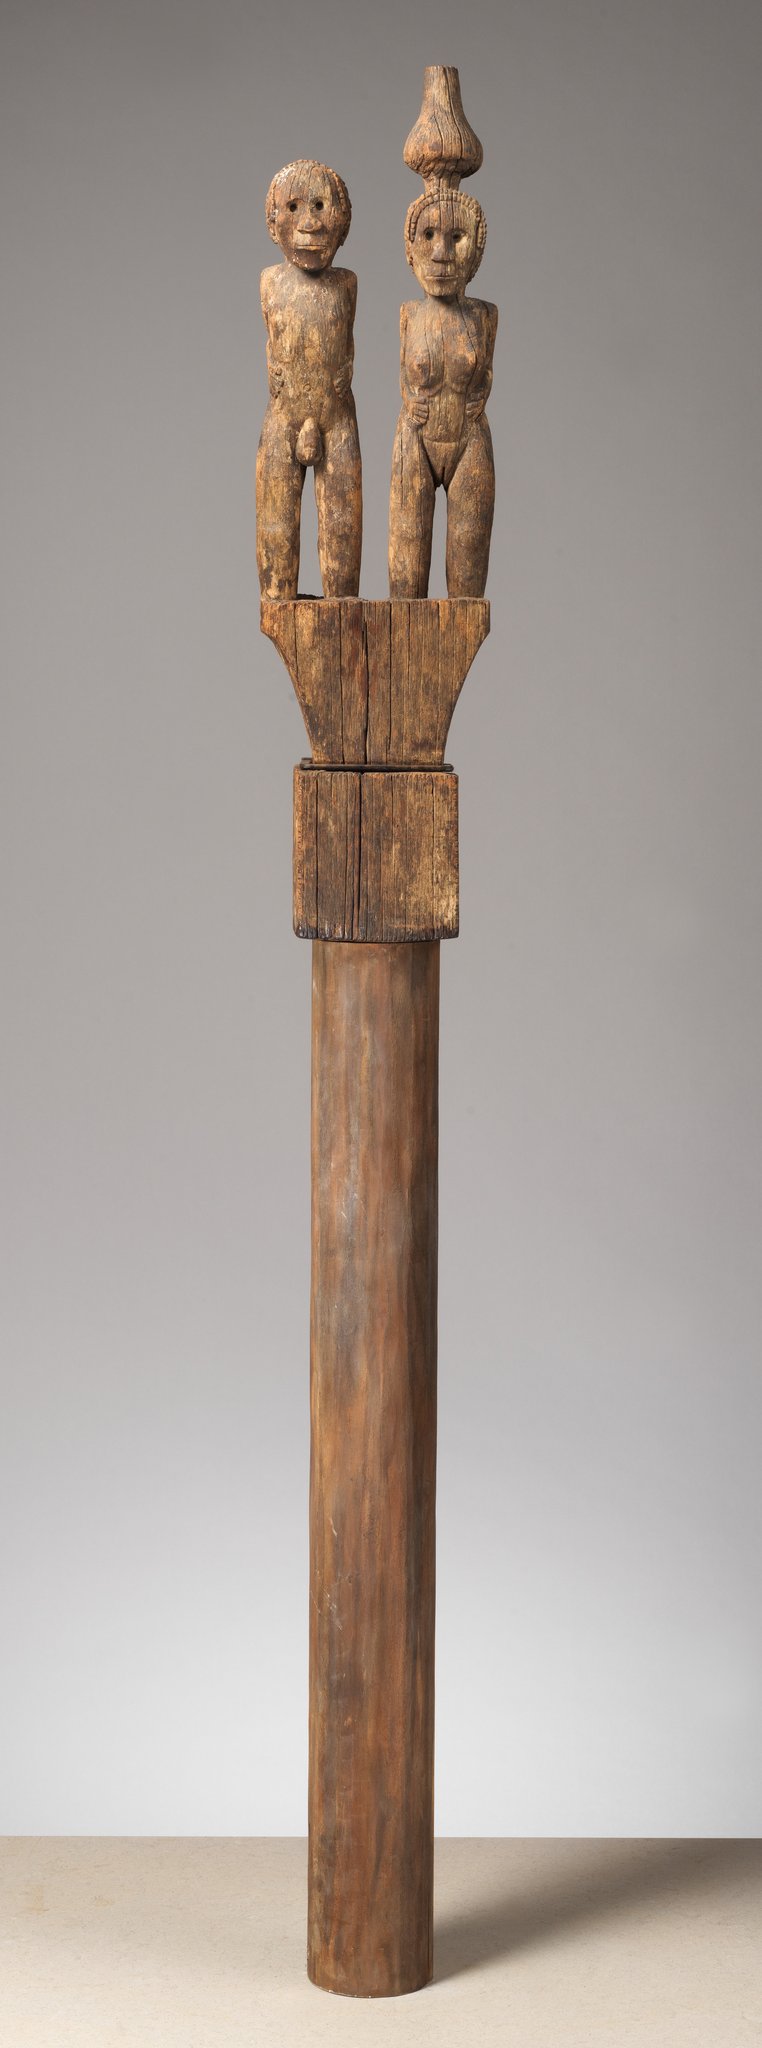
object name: couple figure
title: Hazomanga finial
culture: sakalava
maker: sakalava artist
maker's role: artist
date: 1601-1800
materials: pigment, wood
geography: madagascar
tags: couples,men,male nudes,women,female nudes